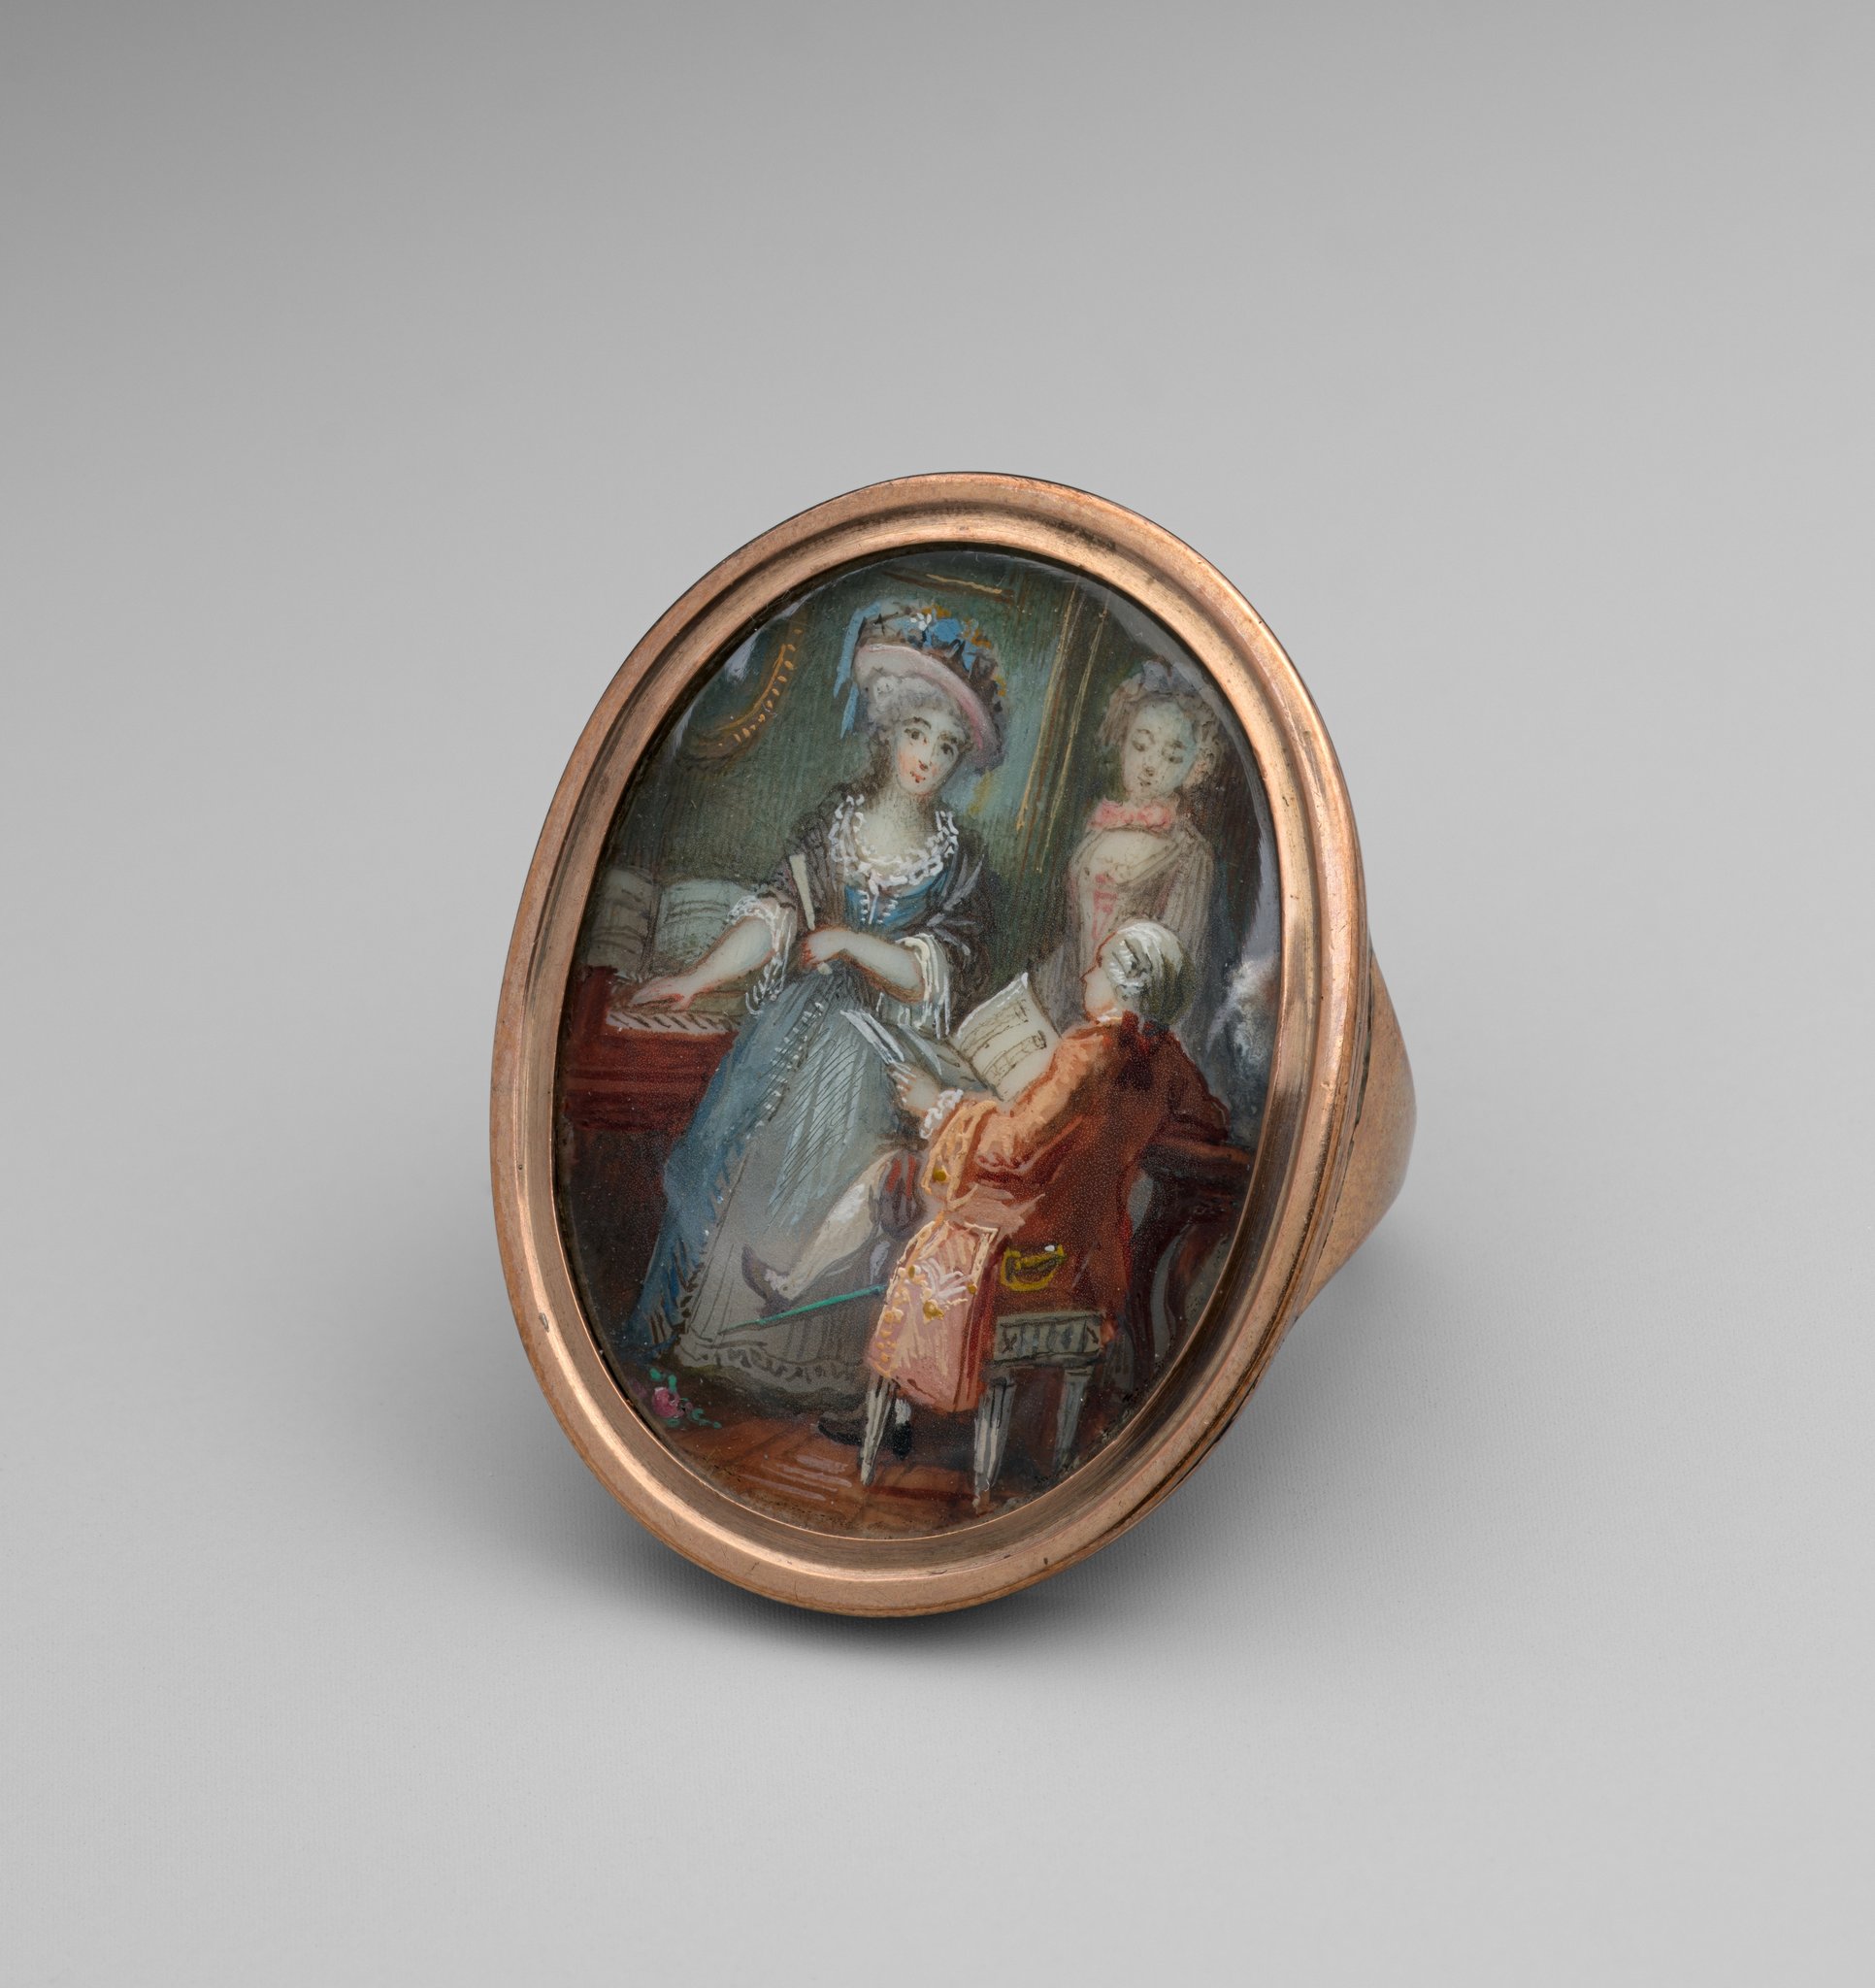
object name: ring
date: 1701-1800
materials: gold, ivory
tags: men,women,music